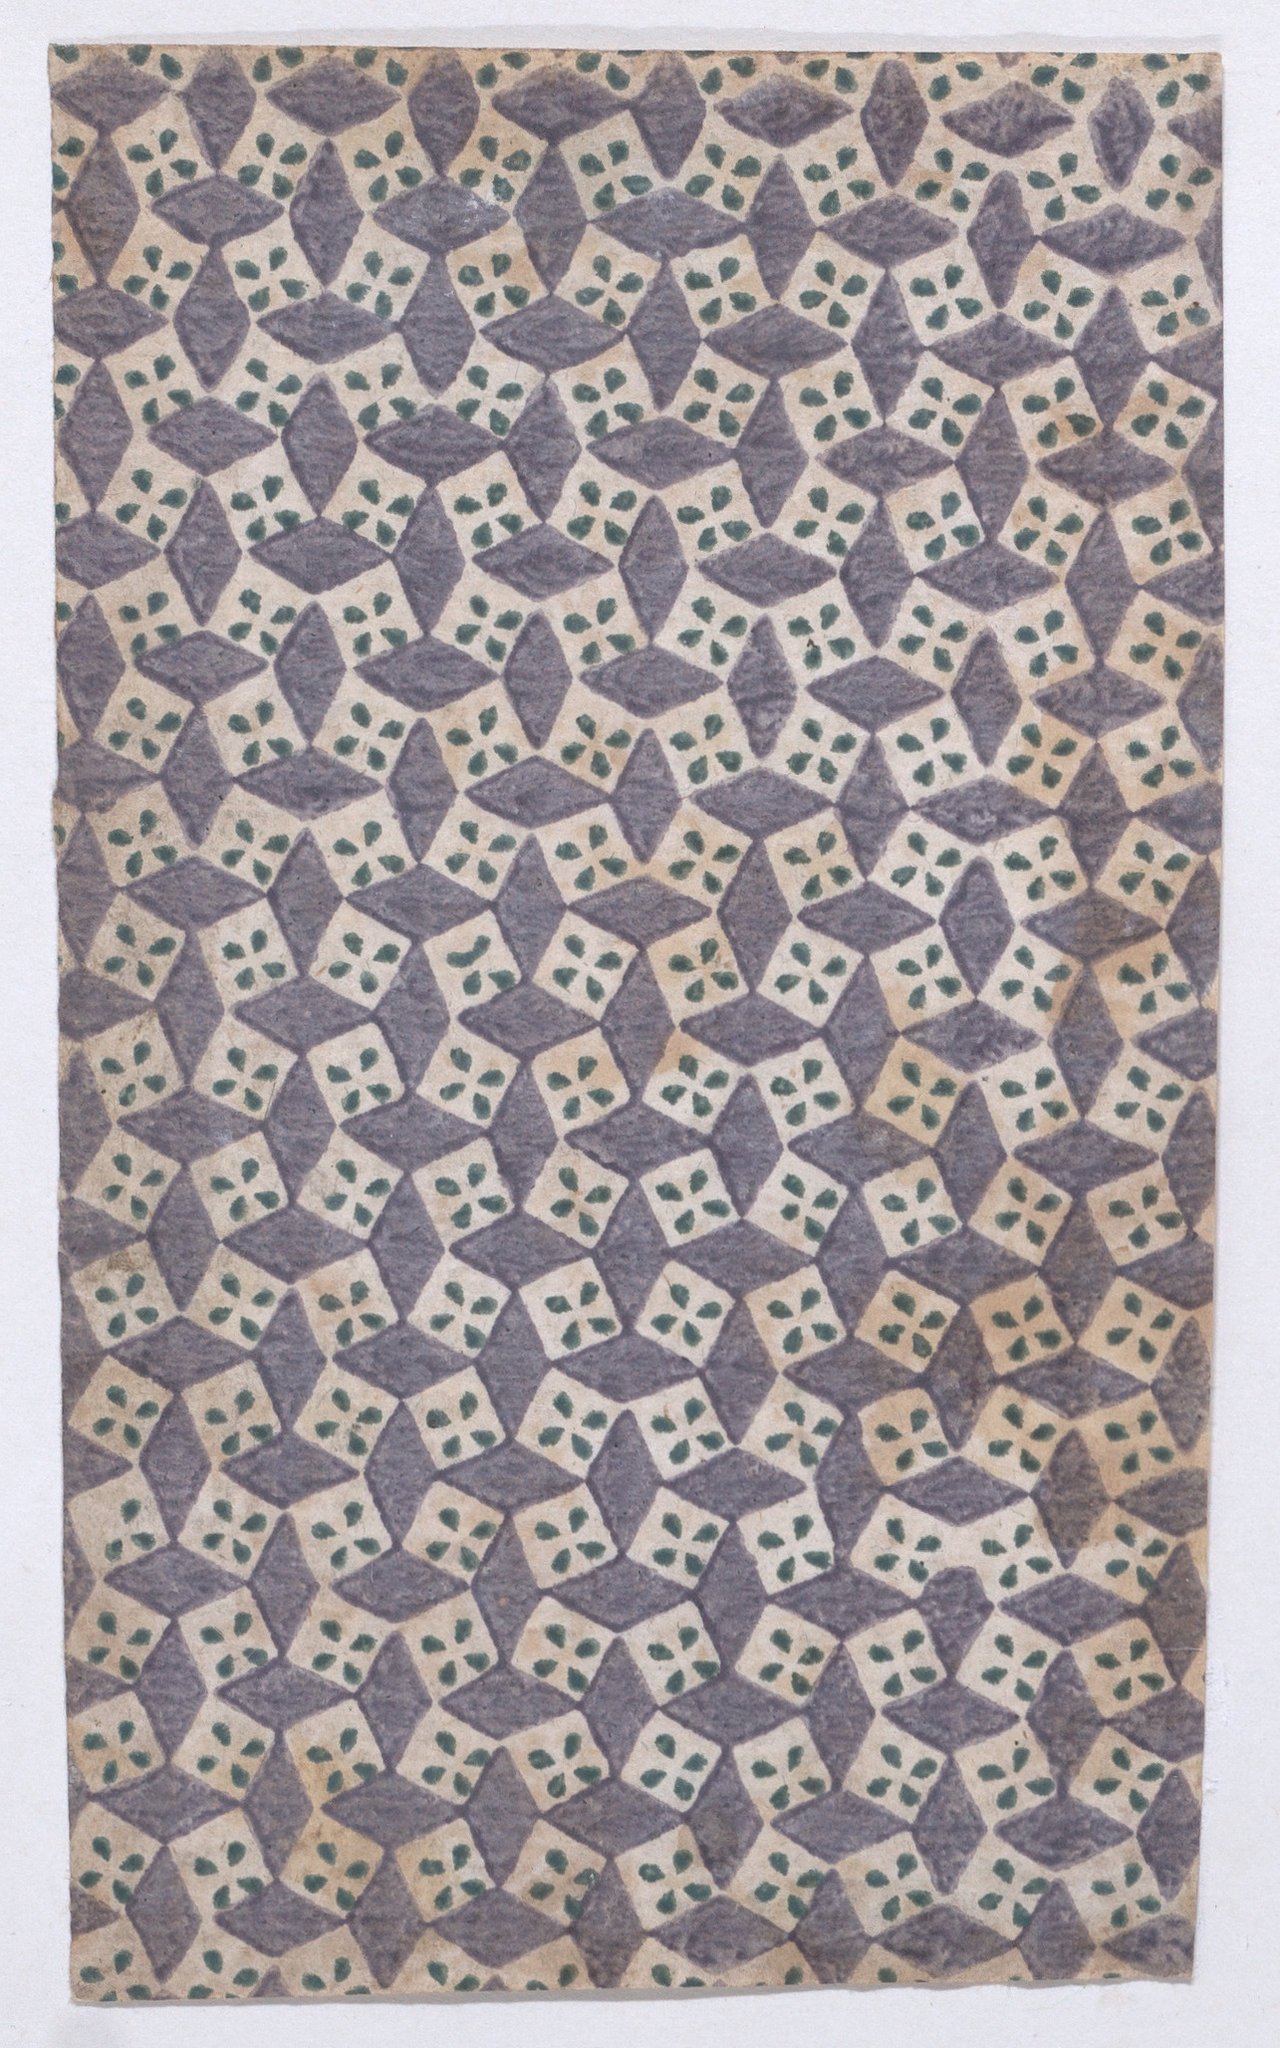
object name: print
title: Sheet with overall geometric pattern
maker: Anonymous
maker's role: artist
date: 1801-1900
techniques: relief print